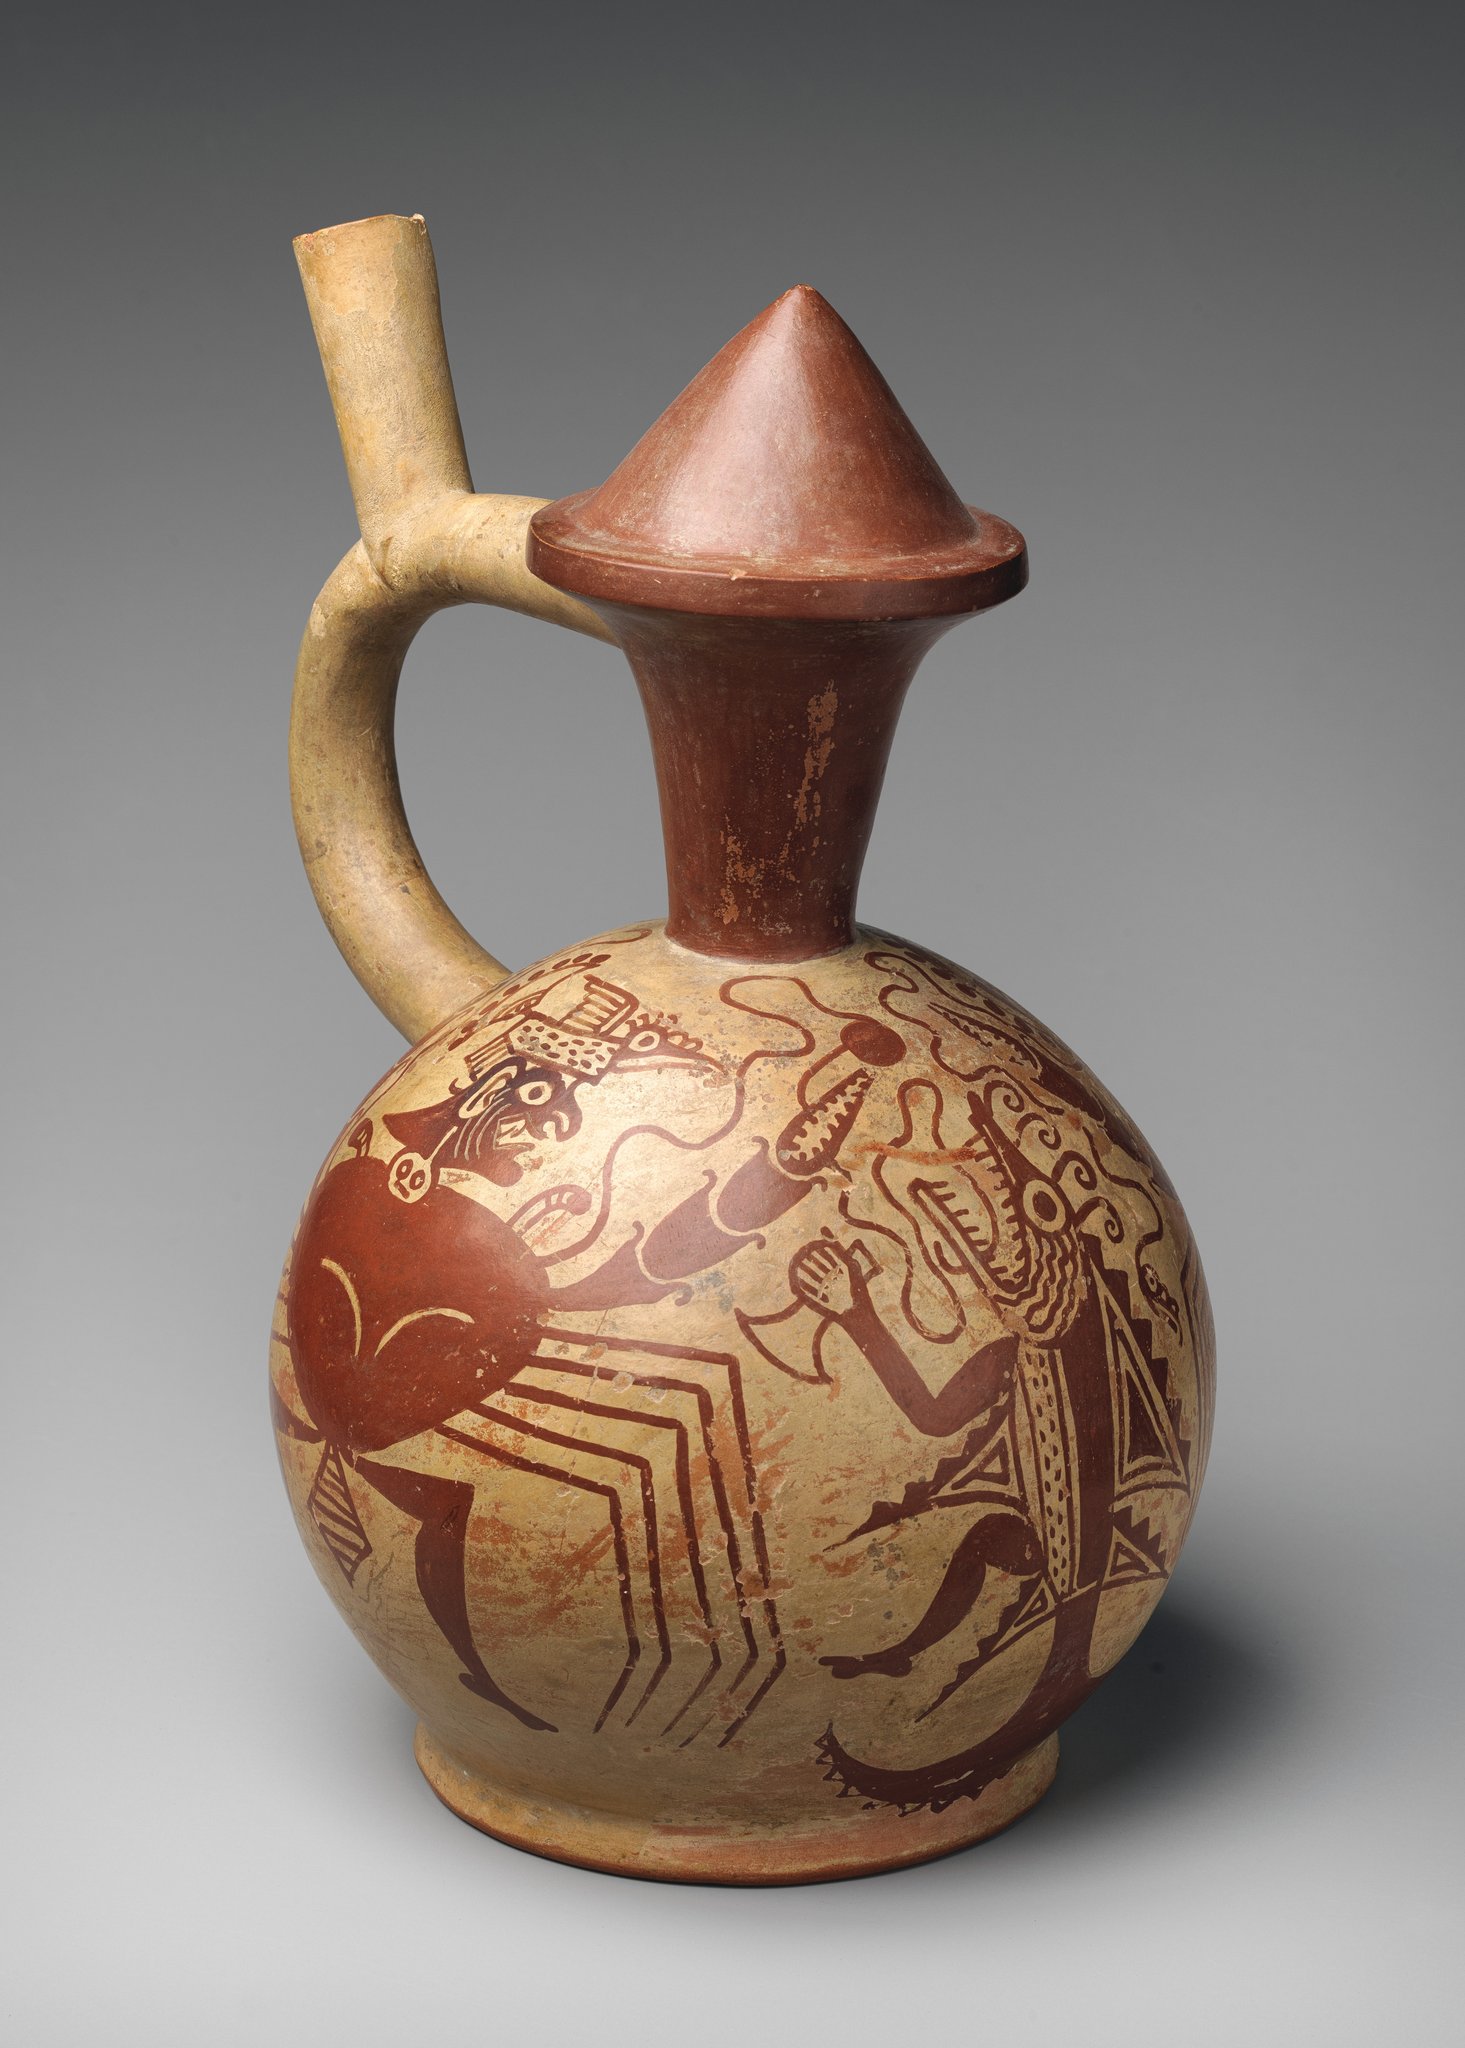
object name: bottle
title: Stirrup-spout bottle with warclub and crab warrior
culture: moche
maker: moche artist(s)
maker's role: artist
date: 500-800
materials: ceramic, pigment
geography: peru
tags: crabs,demons